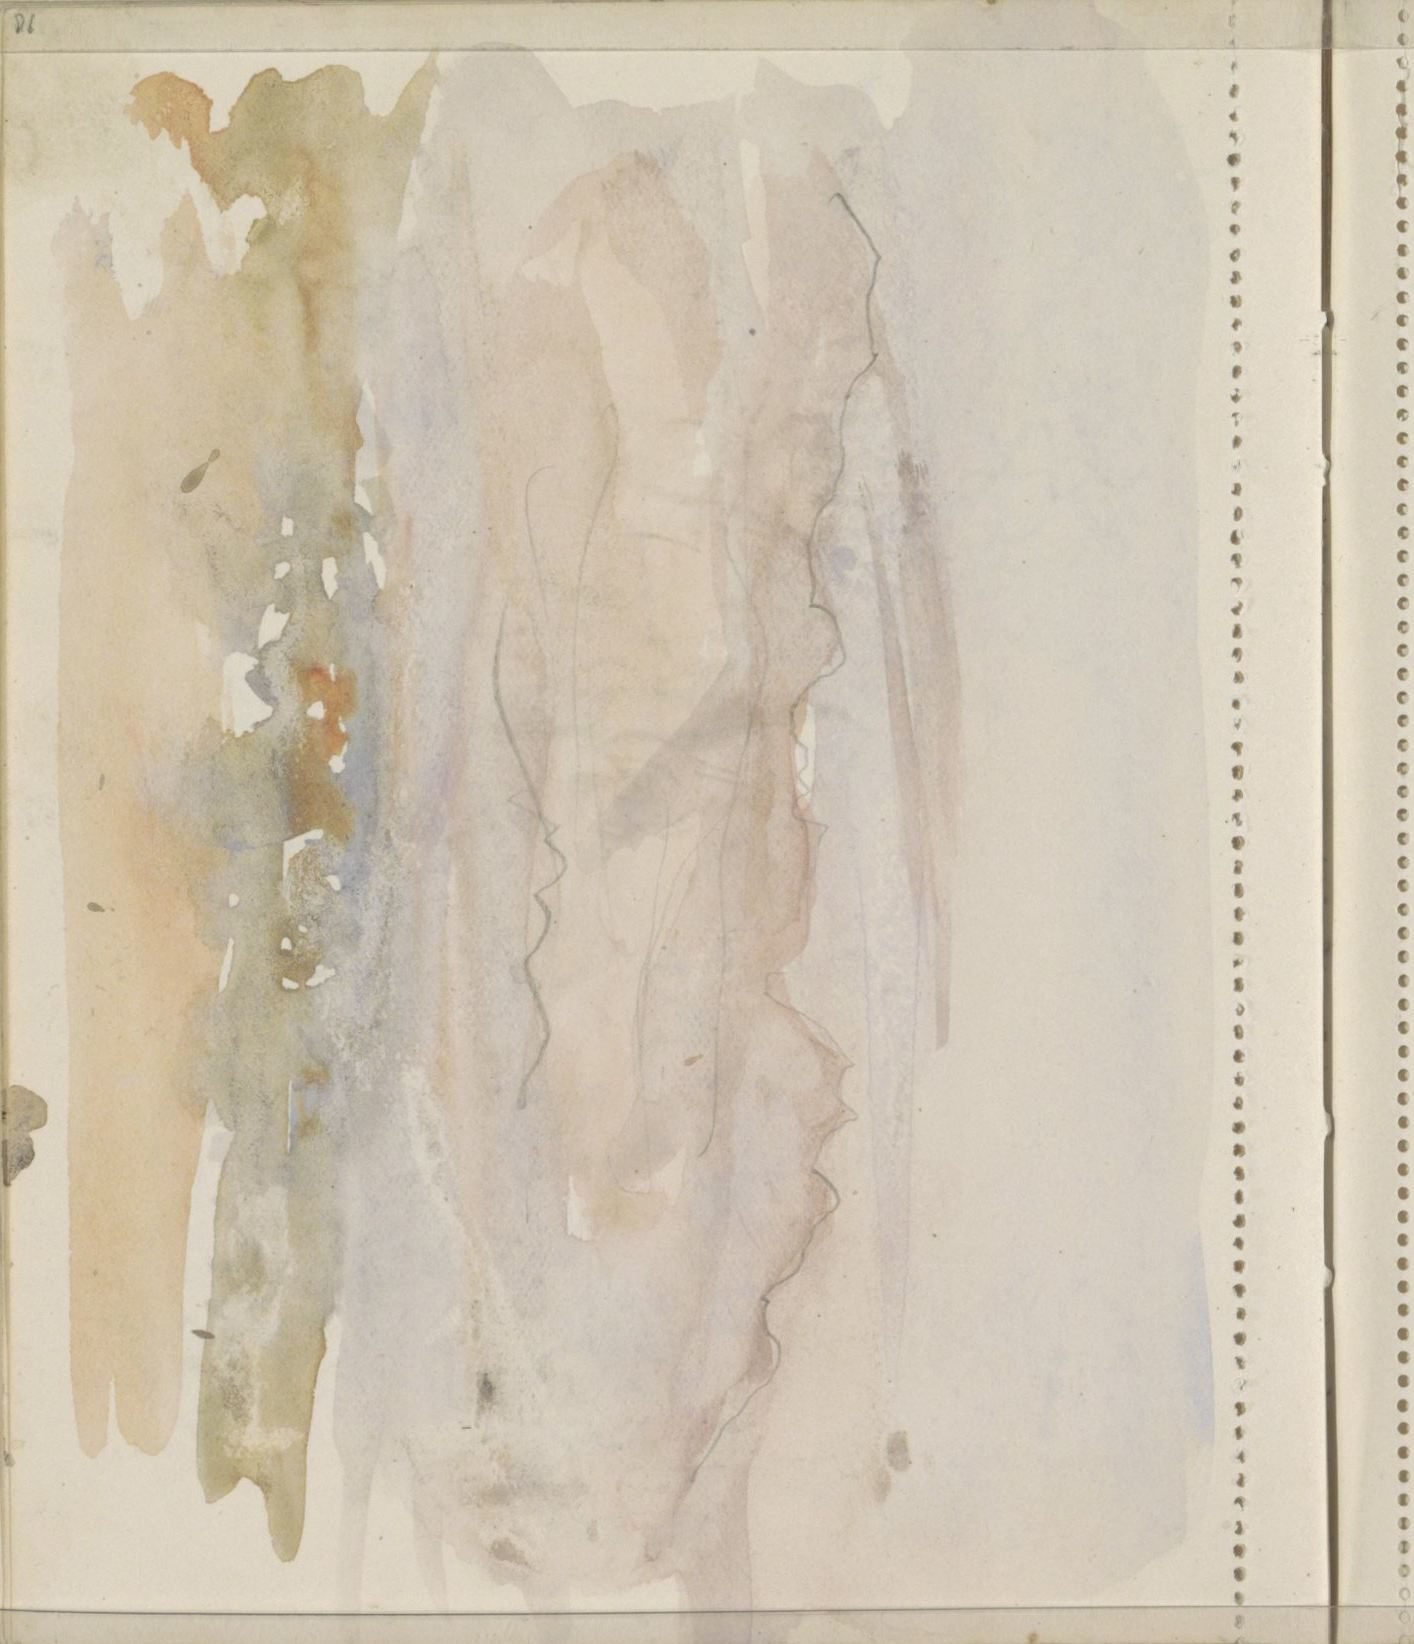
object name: sketchbook leaf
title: Berglandschap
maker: marius bauer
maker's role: draughtsman, print maker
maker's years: 1867-1932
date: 1925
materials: paper, pencil, watercolor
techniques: brush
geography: indonesia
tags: landscapes, mountains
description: Pagina 86 uit een schetsboek met 67 bladen.